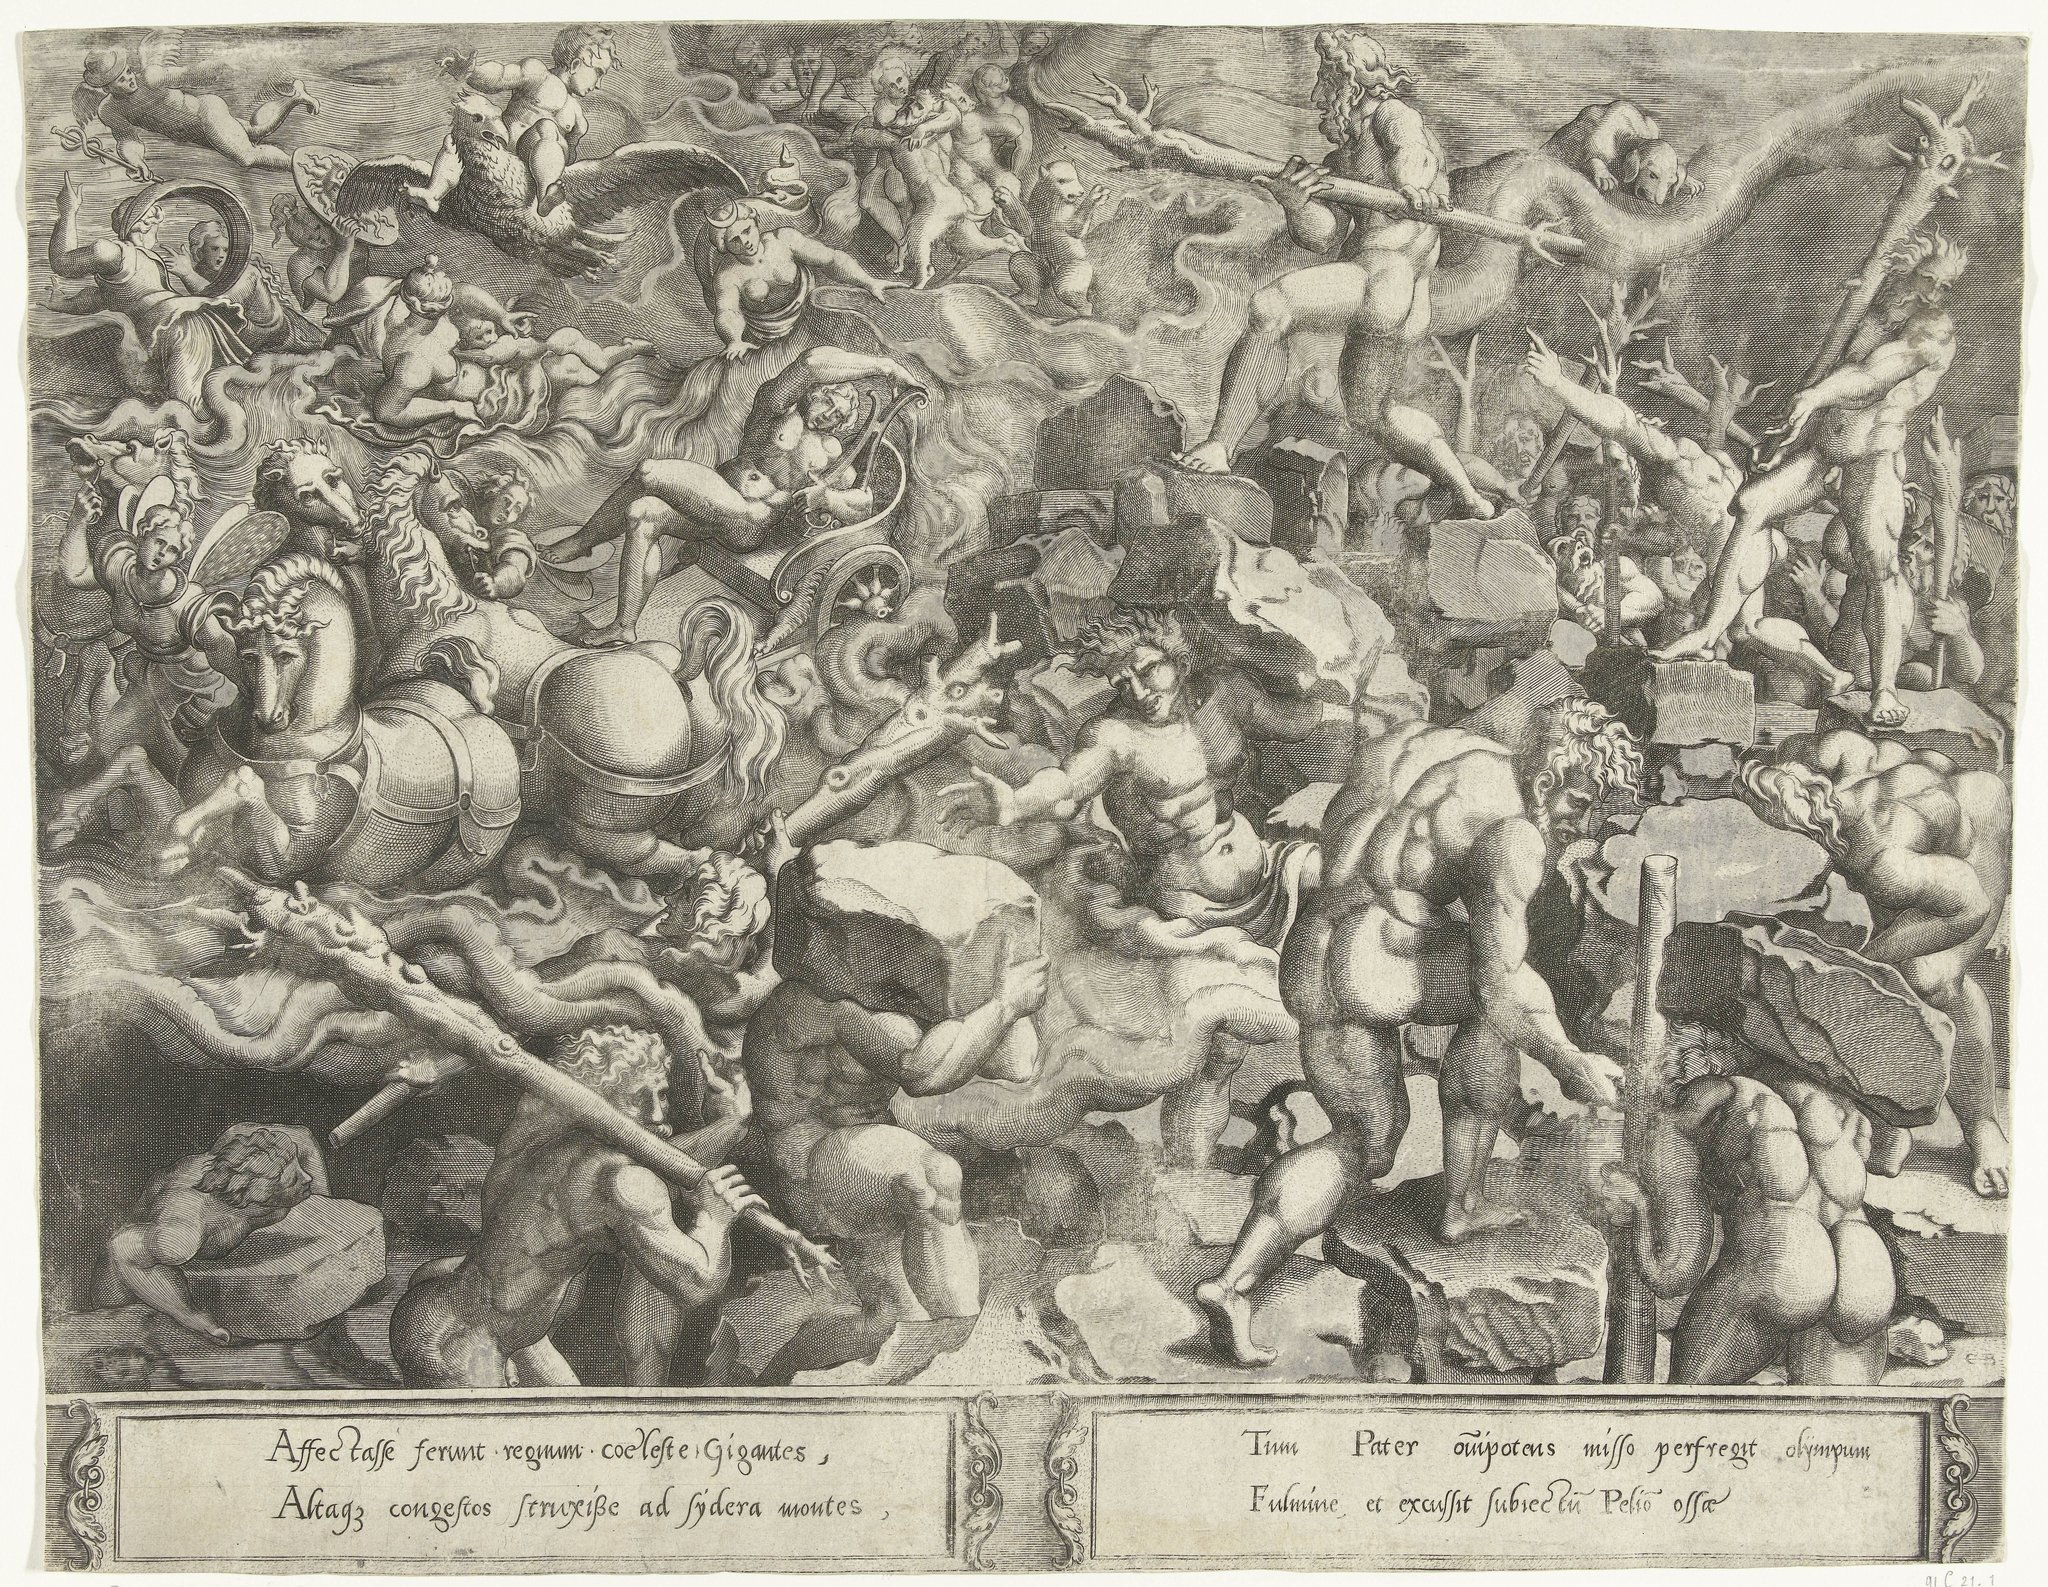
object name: print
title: Strijd tussen de goden en de giganten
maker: cornelis bos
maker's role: print maker, printer, publisher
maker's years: 1510-1566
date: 1537-1555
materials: paper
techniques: engraving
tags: battle of the giants against the gods: gigantomachy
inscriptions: collector's mark: Lugt 240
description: De giganten vallen de Olympus aan. Uit rotsblokken proberen ze een berg te bouwen om de wolken te bereiken. Ze zijn met afgebroken boomstammen gewapend. De goden vluchtten met wagen of vliegend. Onder in een cartouche een Latijns vers over de strijd tussen de goden en giganten.